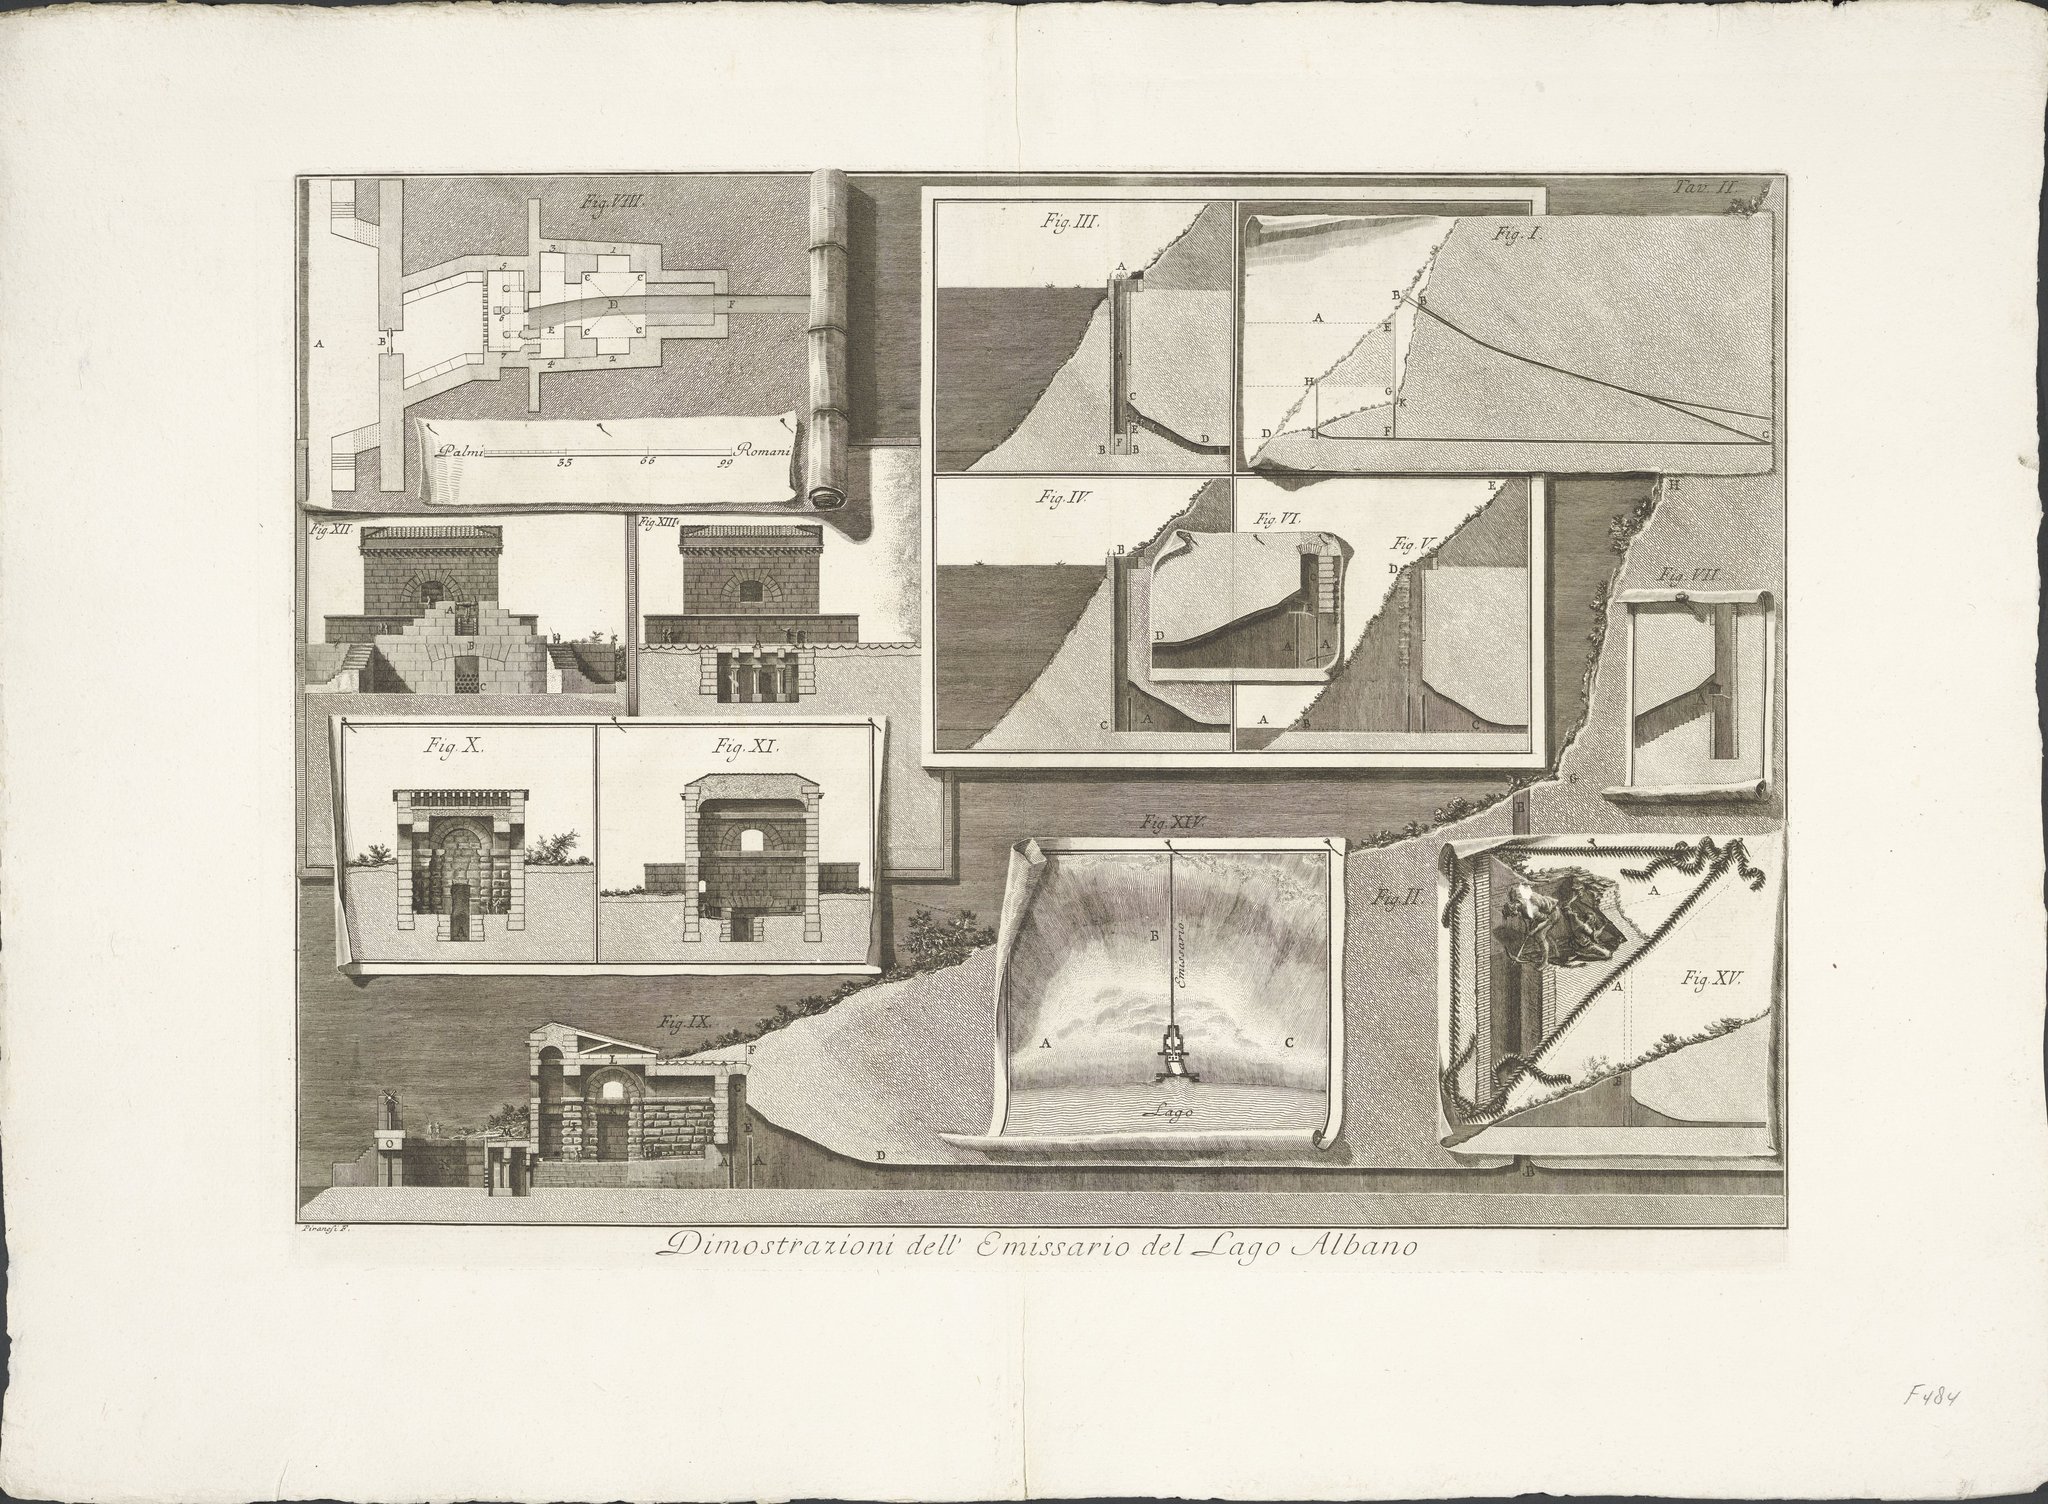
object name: print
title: Descrizione e Disegno dell'Emissario del Lago Albano di Gio Battista Piranesi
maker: giovanni battista piranesi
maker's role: designer, draughtsman, print maker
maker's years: 1720-1778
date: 1762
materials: paper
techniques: etching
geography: rome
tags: sewers, lake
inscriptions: collector's mark: Lugt 2228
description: Deze prent maakt deel uit van de serie 'Descrizione e Disegno dell'Emissario del Lago Albano'. De serie bestaat uit een titelprent, een vignet, een ornamentele letter en negen prenten.